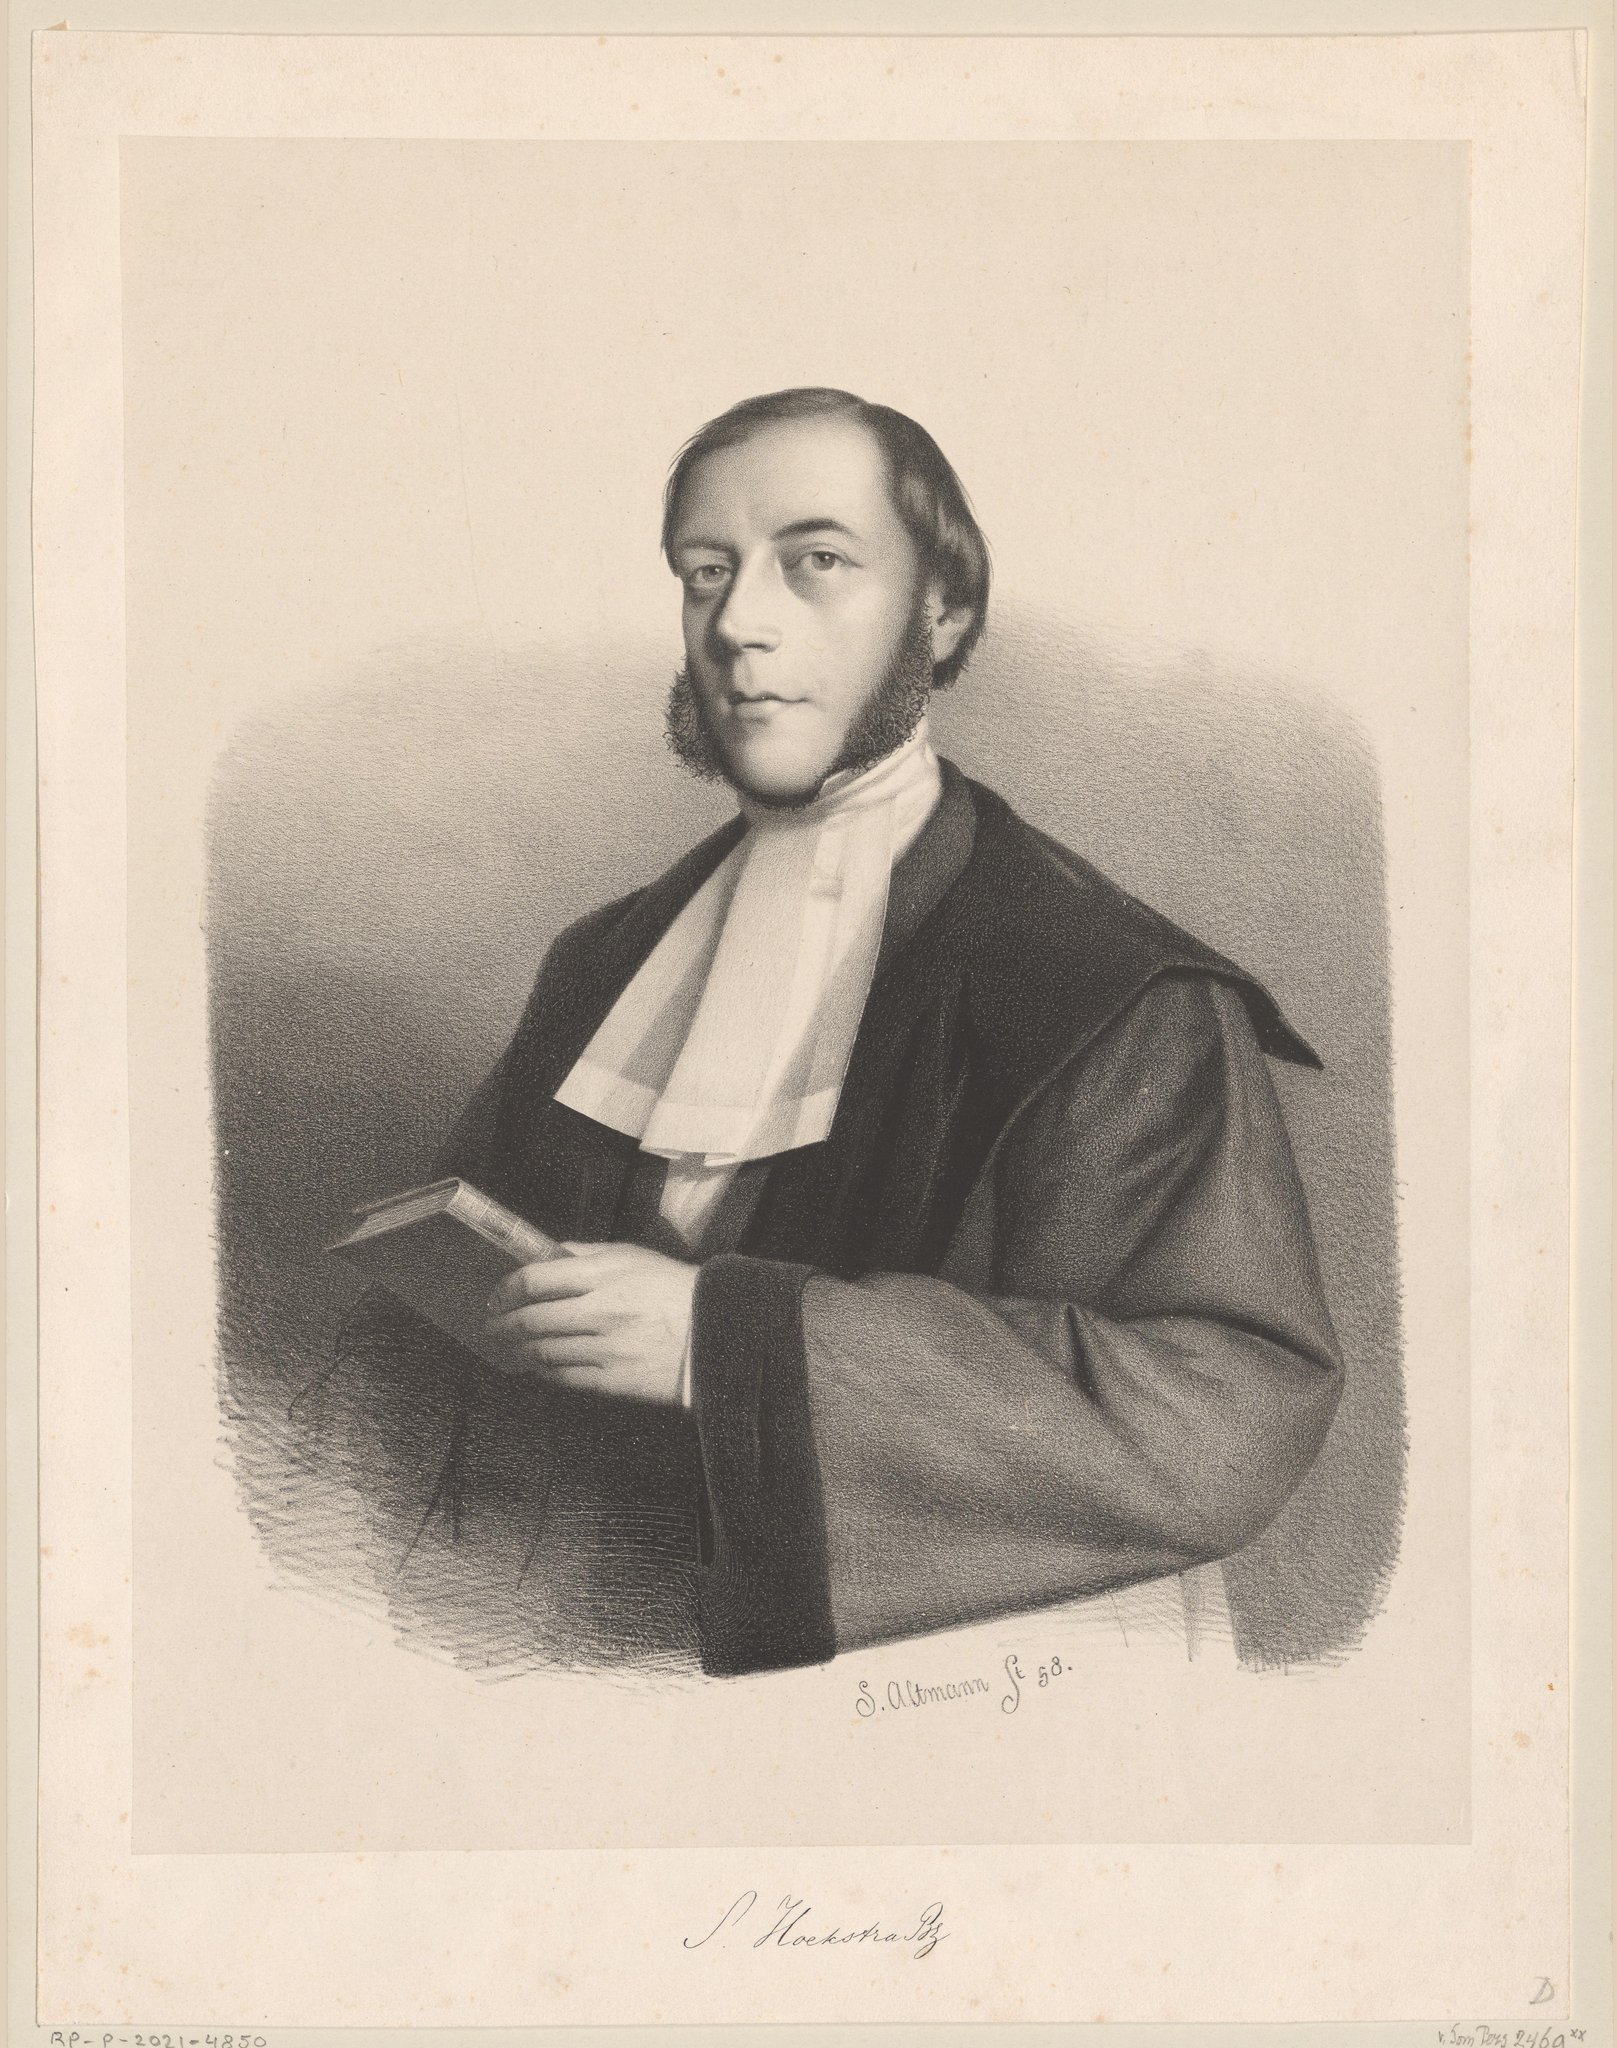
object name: print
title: Portret van Sytze Hoekstra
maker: s. altmann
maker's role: painter, print maker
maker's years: 1822-1890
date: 1858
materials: paper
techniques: lithograph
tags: historical persons, book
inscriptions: date